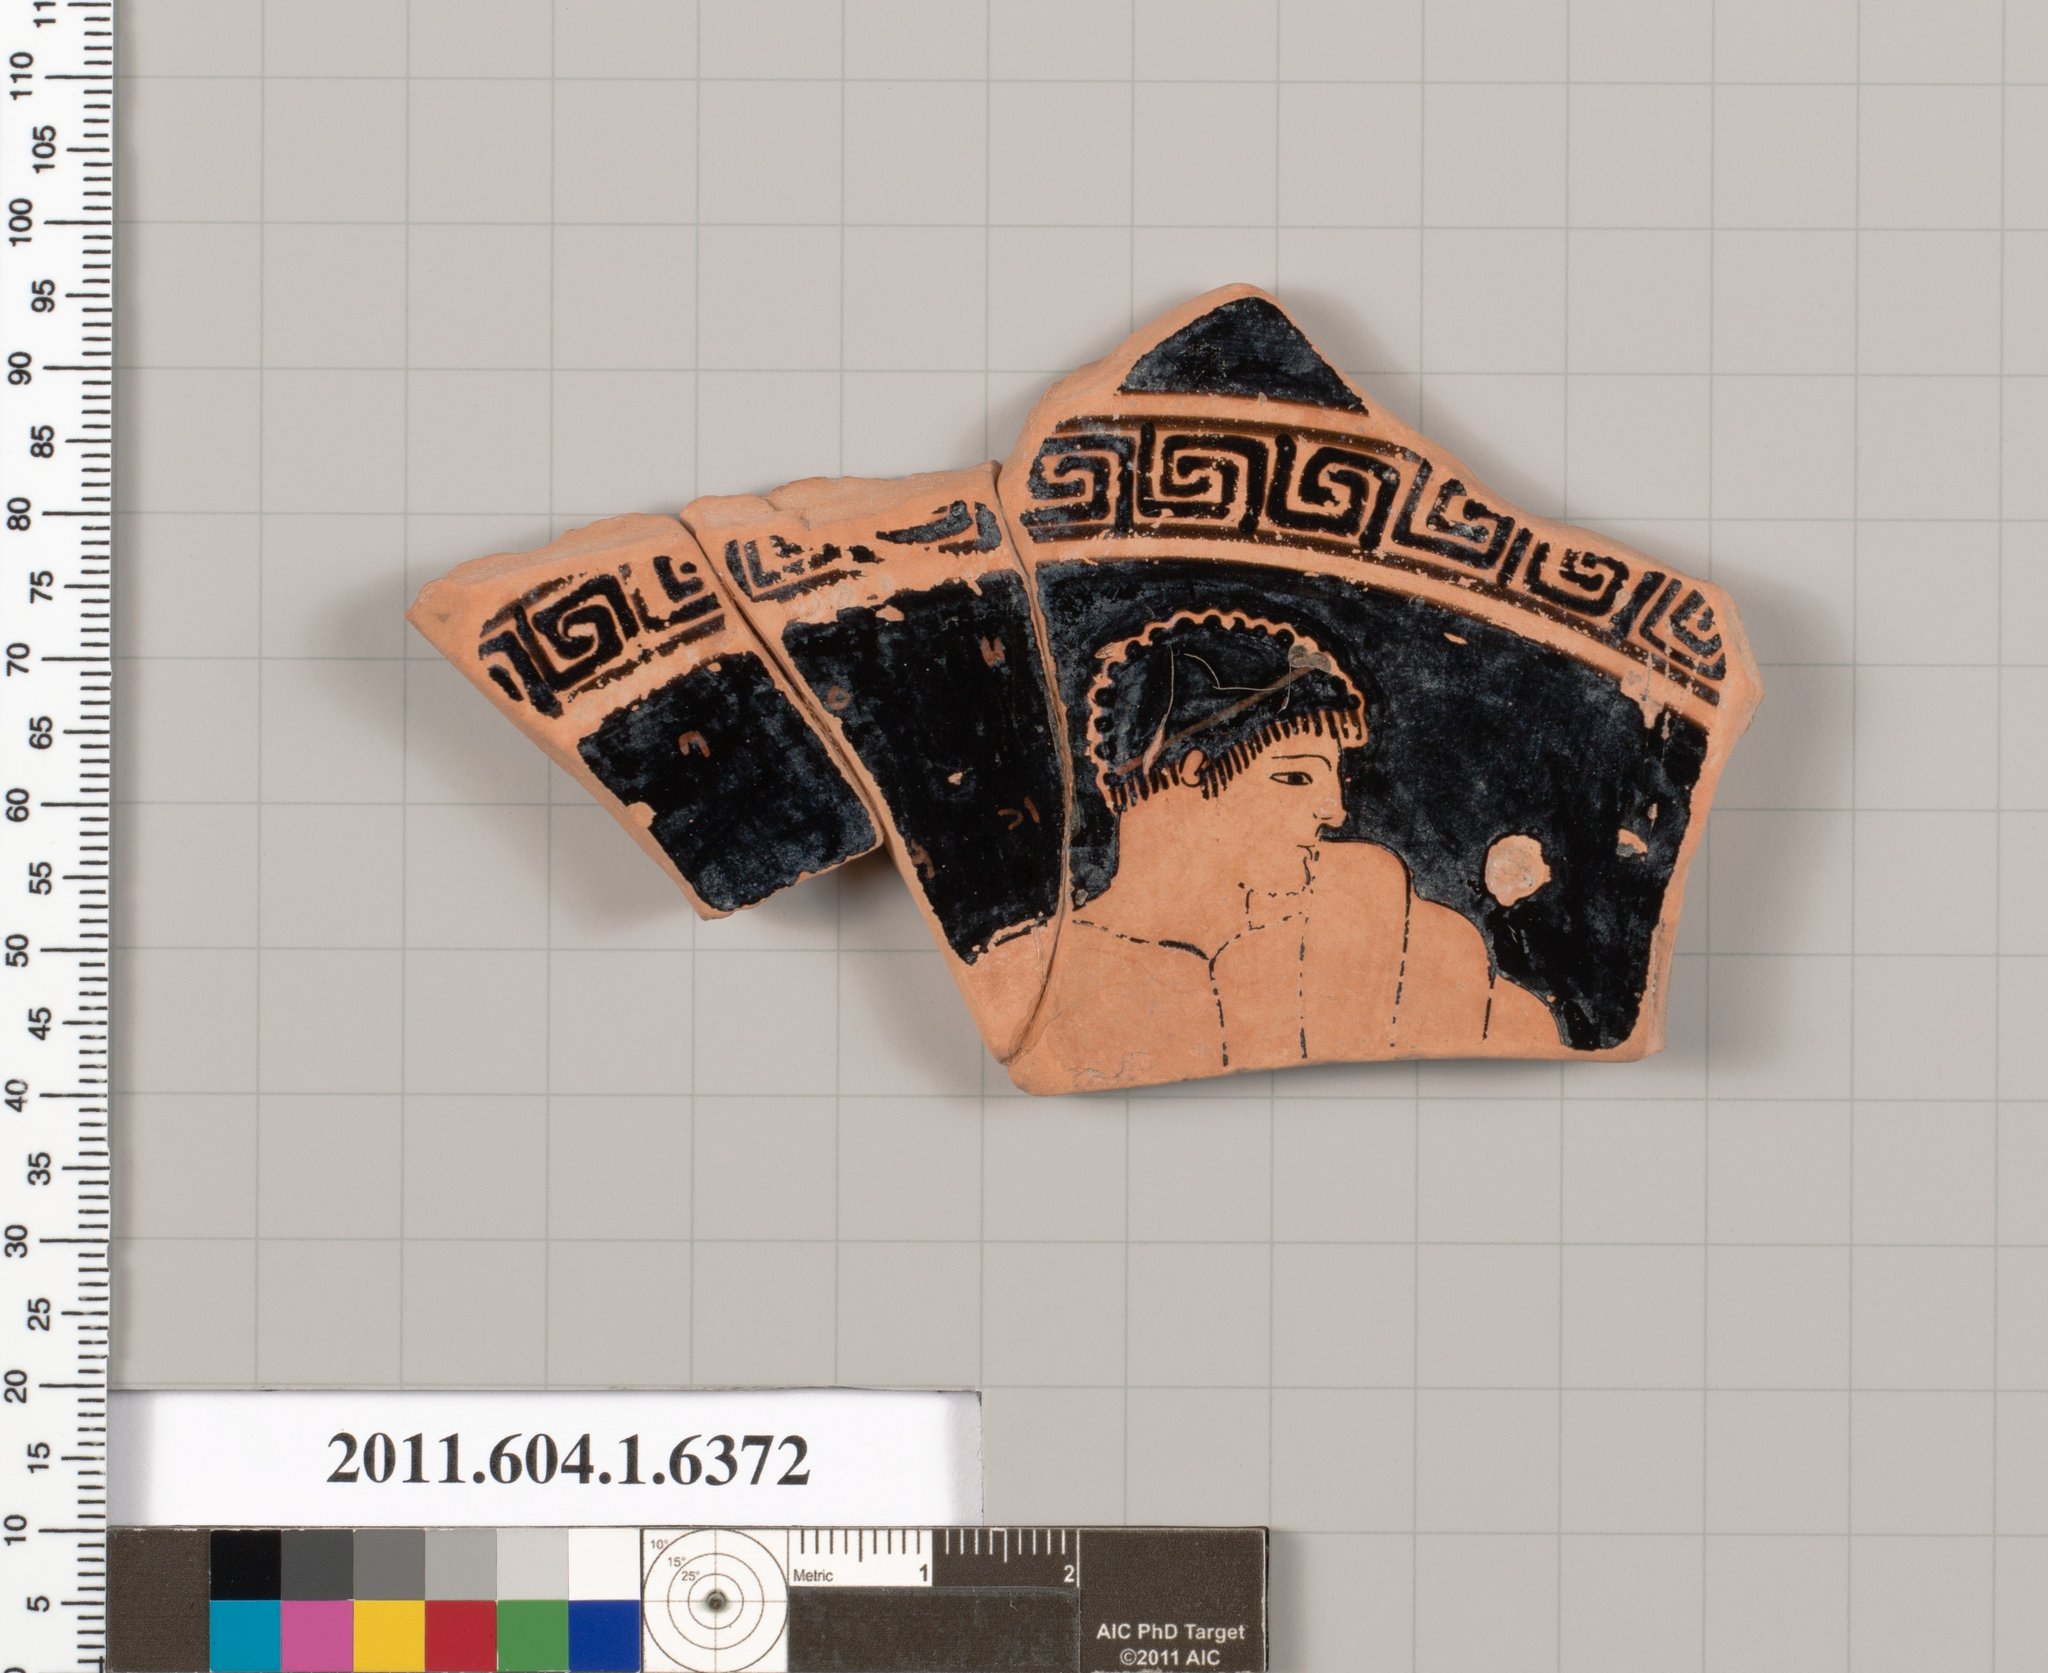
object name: kylix fragment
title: Terracotta fragment of a kylix (drinking cup)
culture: greek, attic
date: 490-480 BCE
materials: terracotta